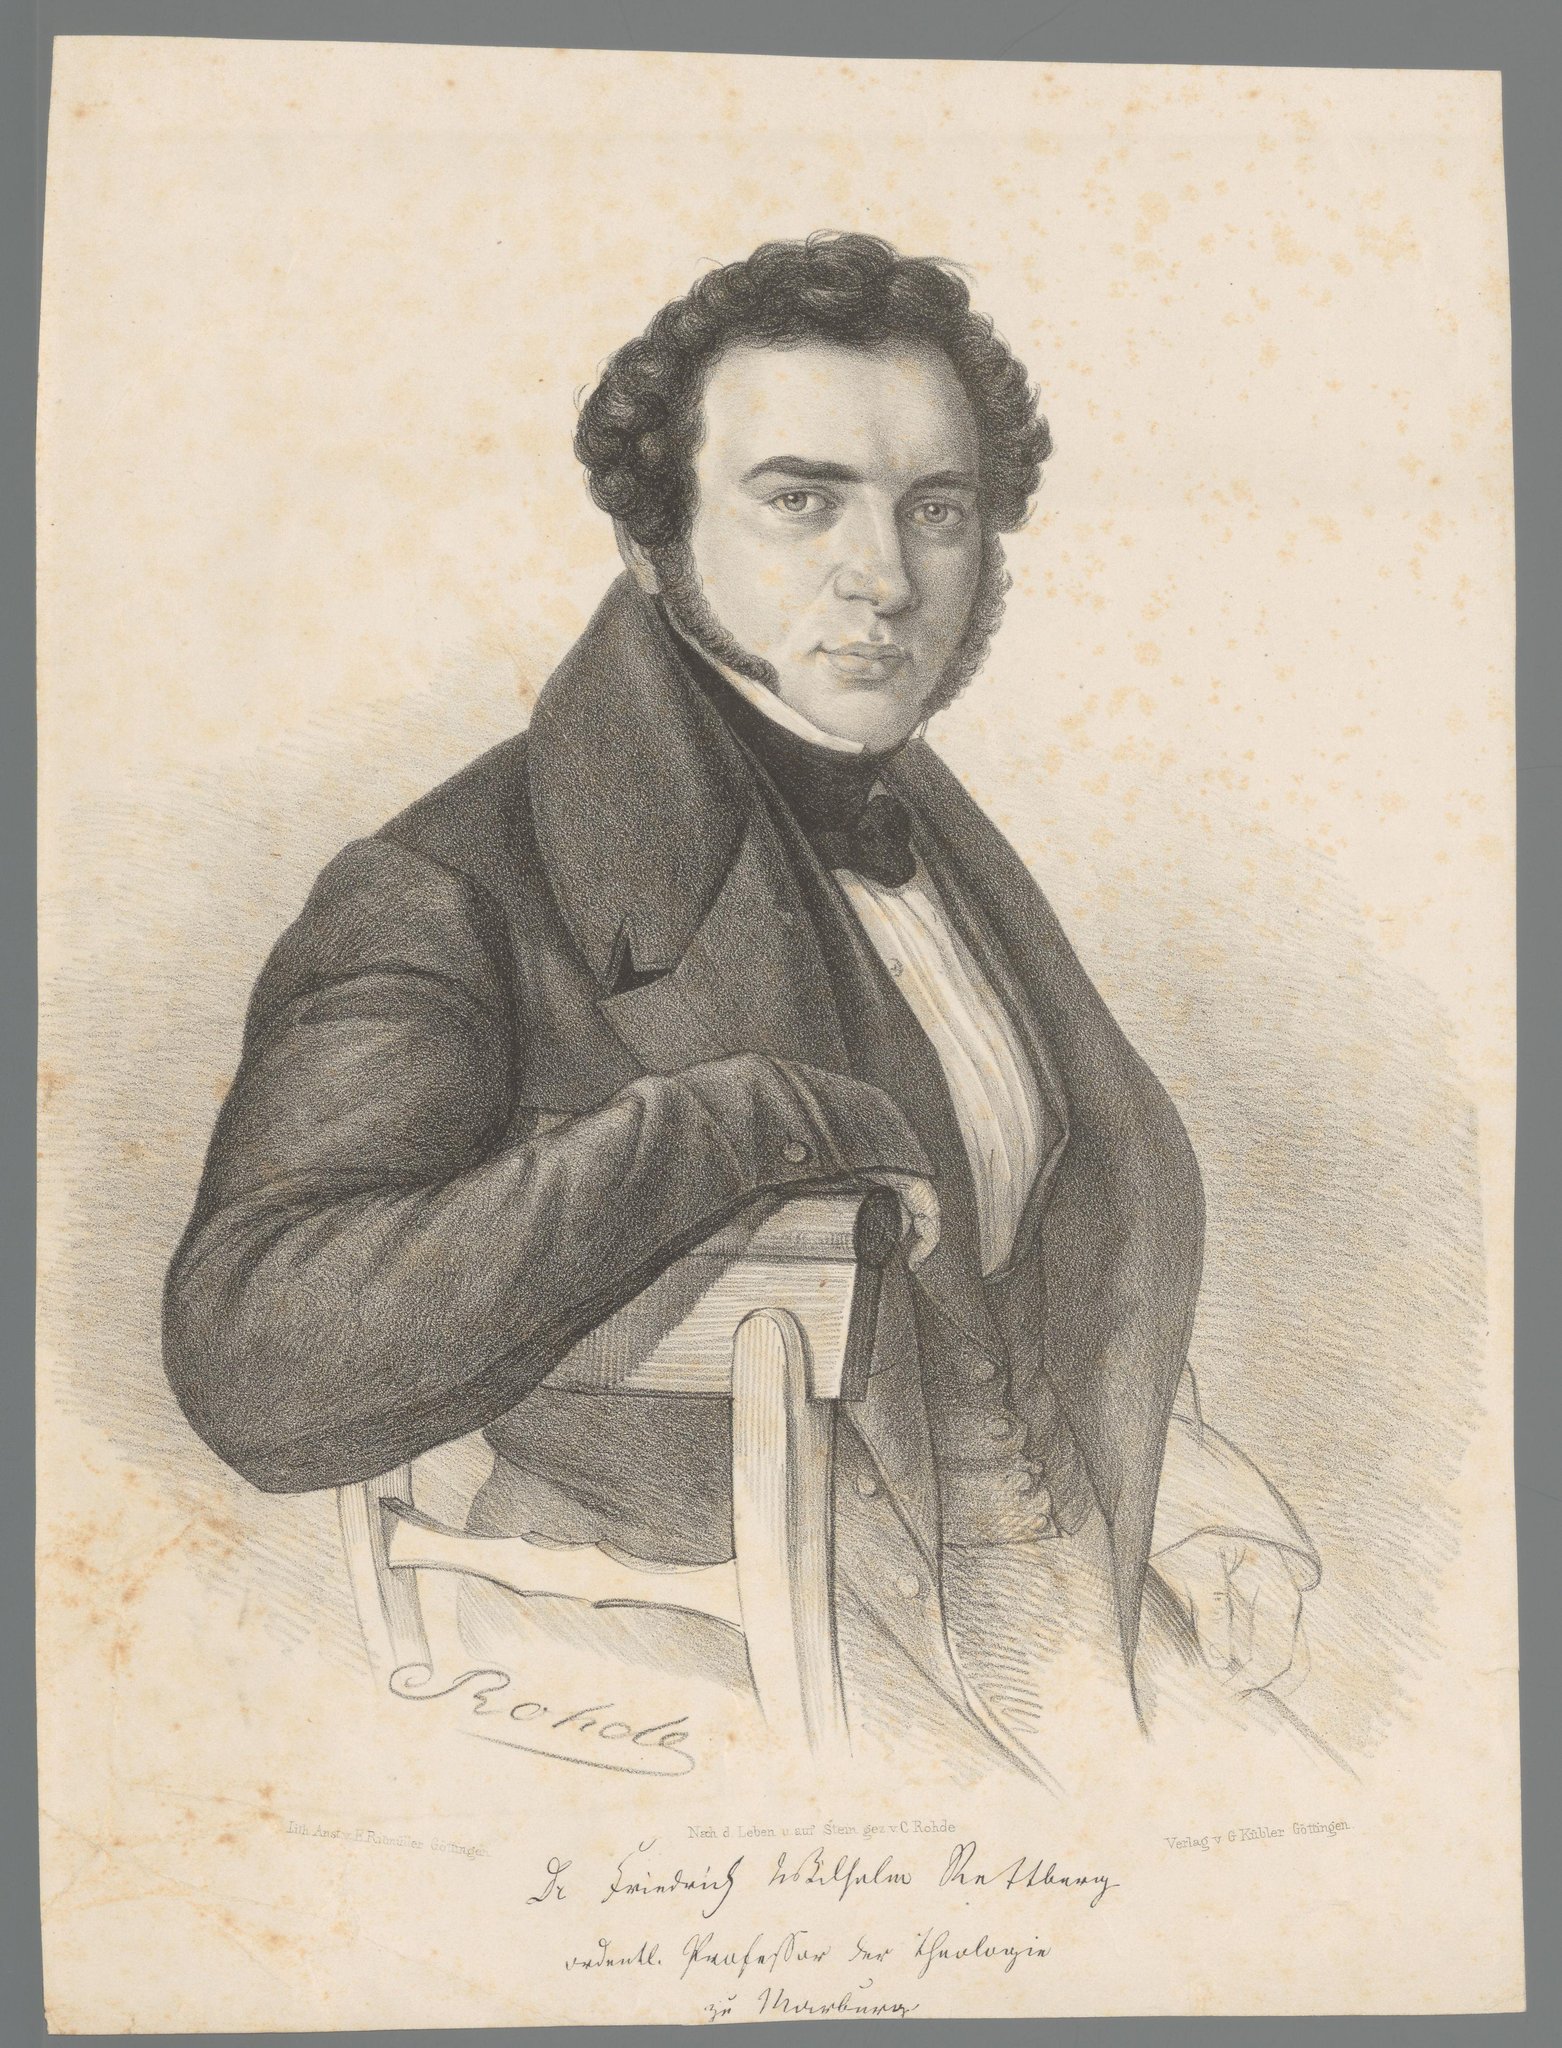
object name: print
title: Portret van Friedrich Wilhelm Rettberg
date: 1825-1830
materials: paper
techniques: lithograph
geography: gottingen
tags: theologian, historical persons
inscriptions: collector's mark: Lugt 2228